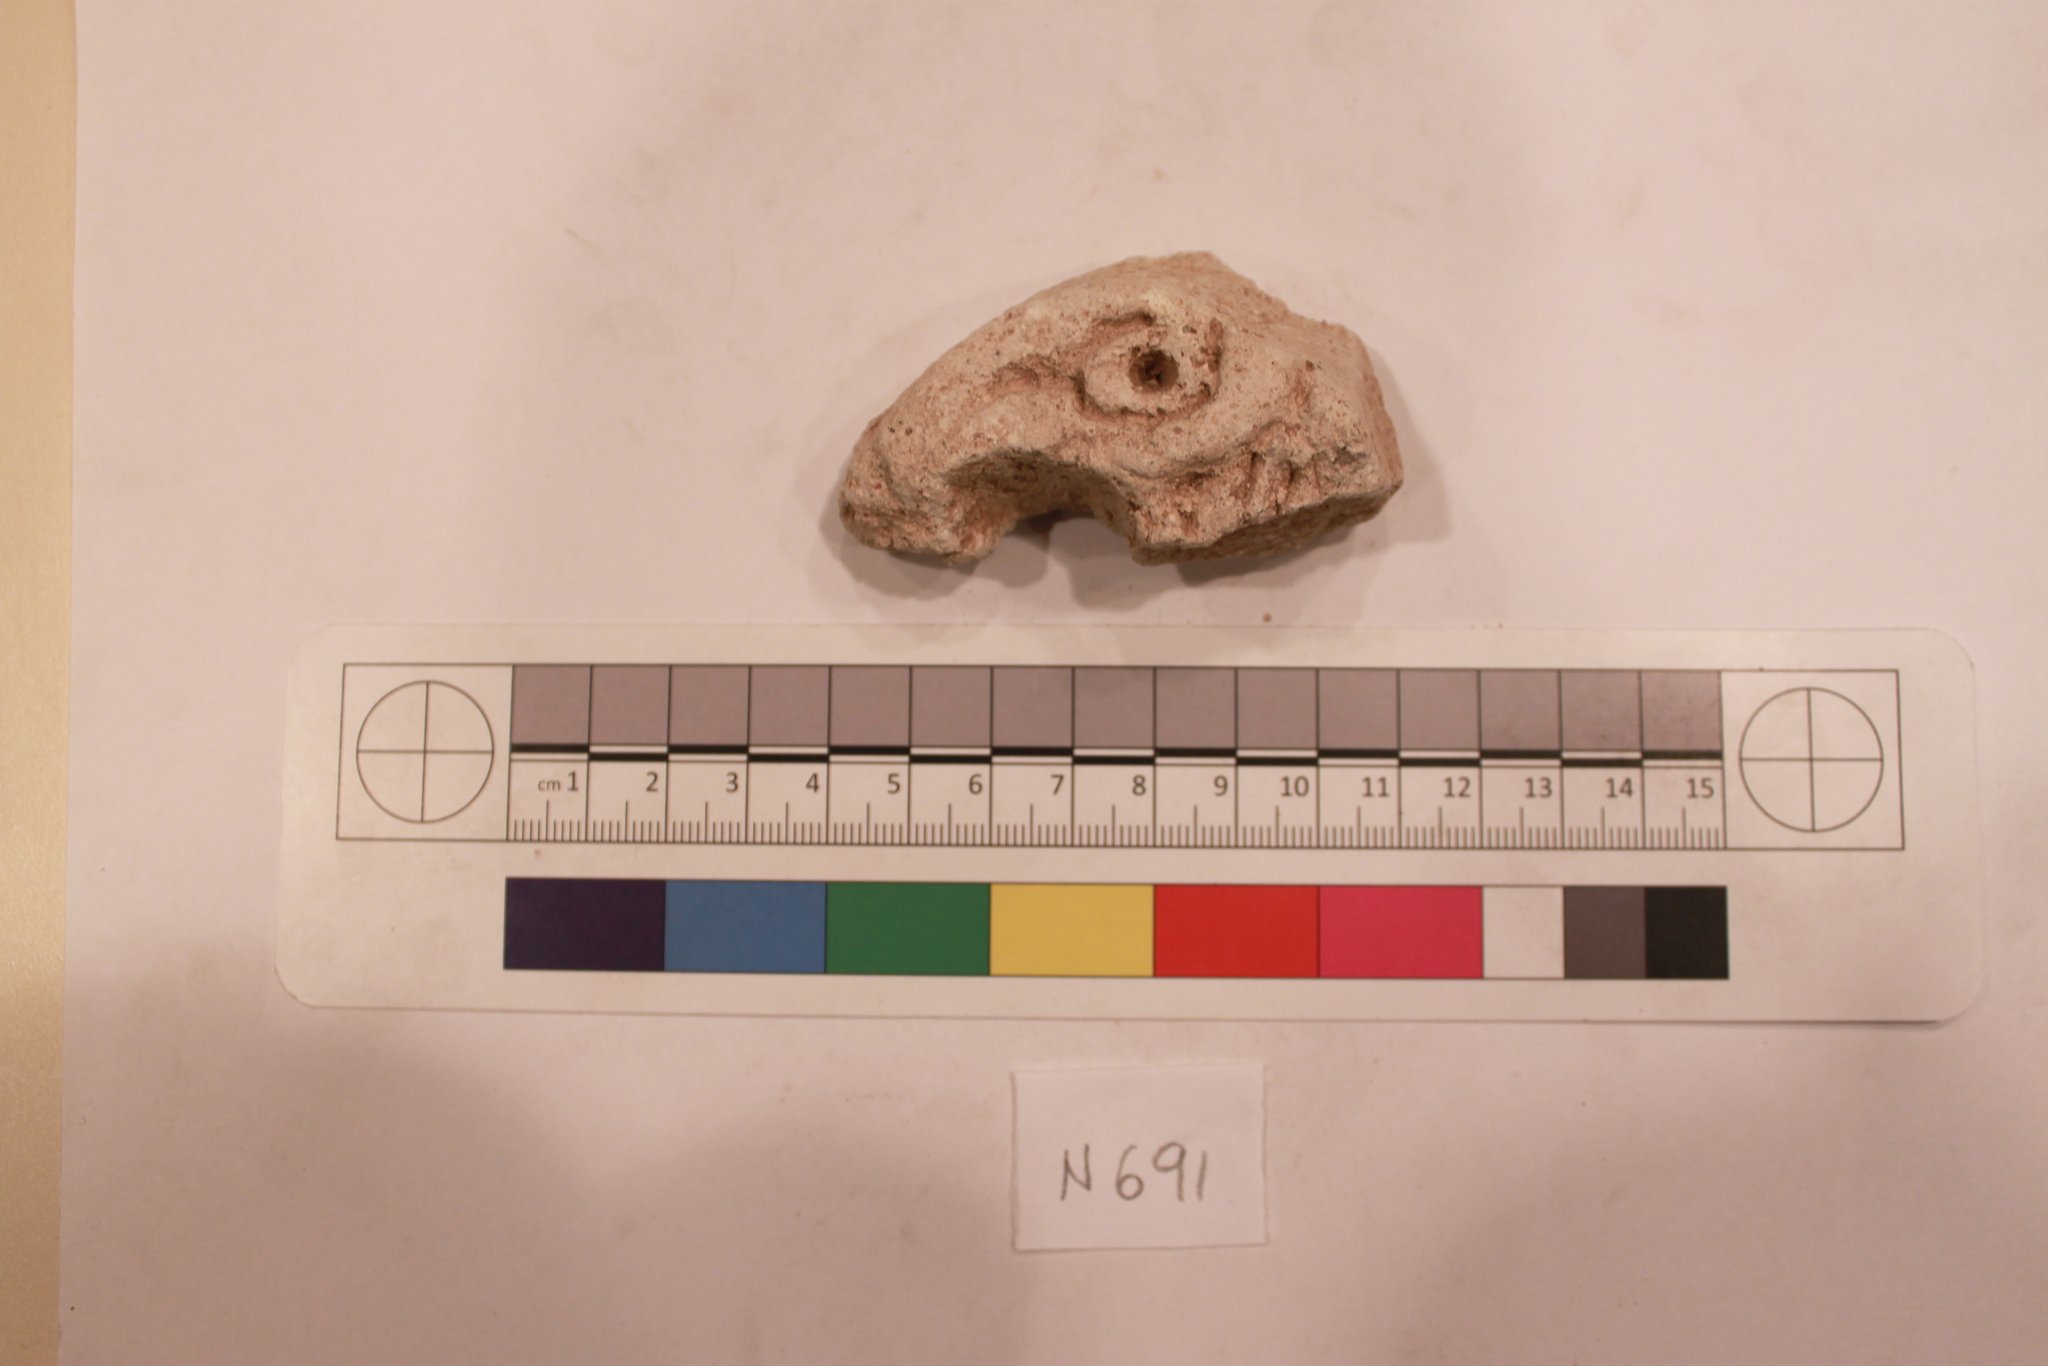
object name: fragment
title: Stucco Fragment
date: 701-1200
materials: plaster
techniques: carving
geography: iran